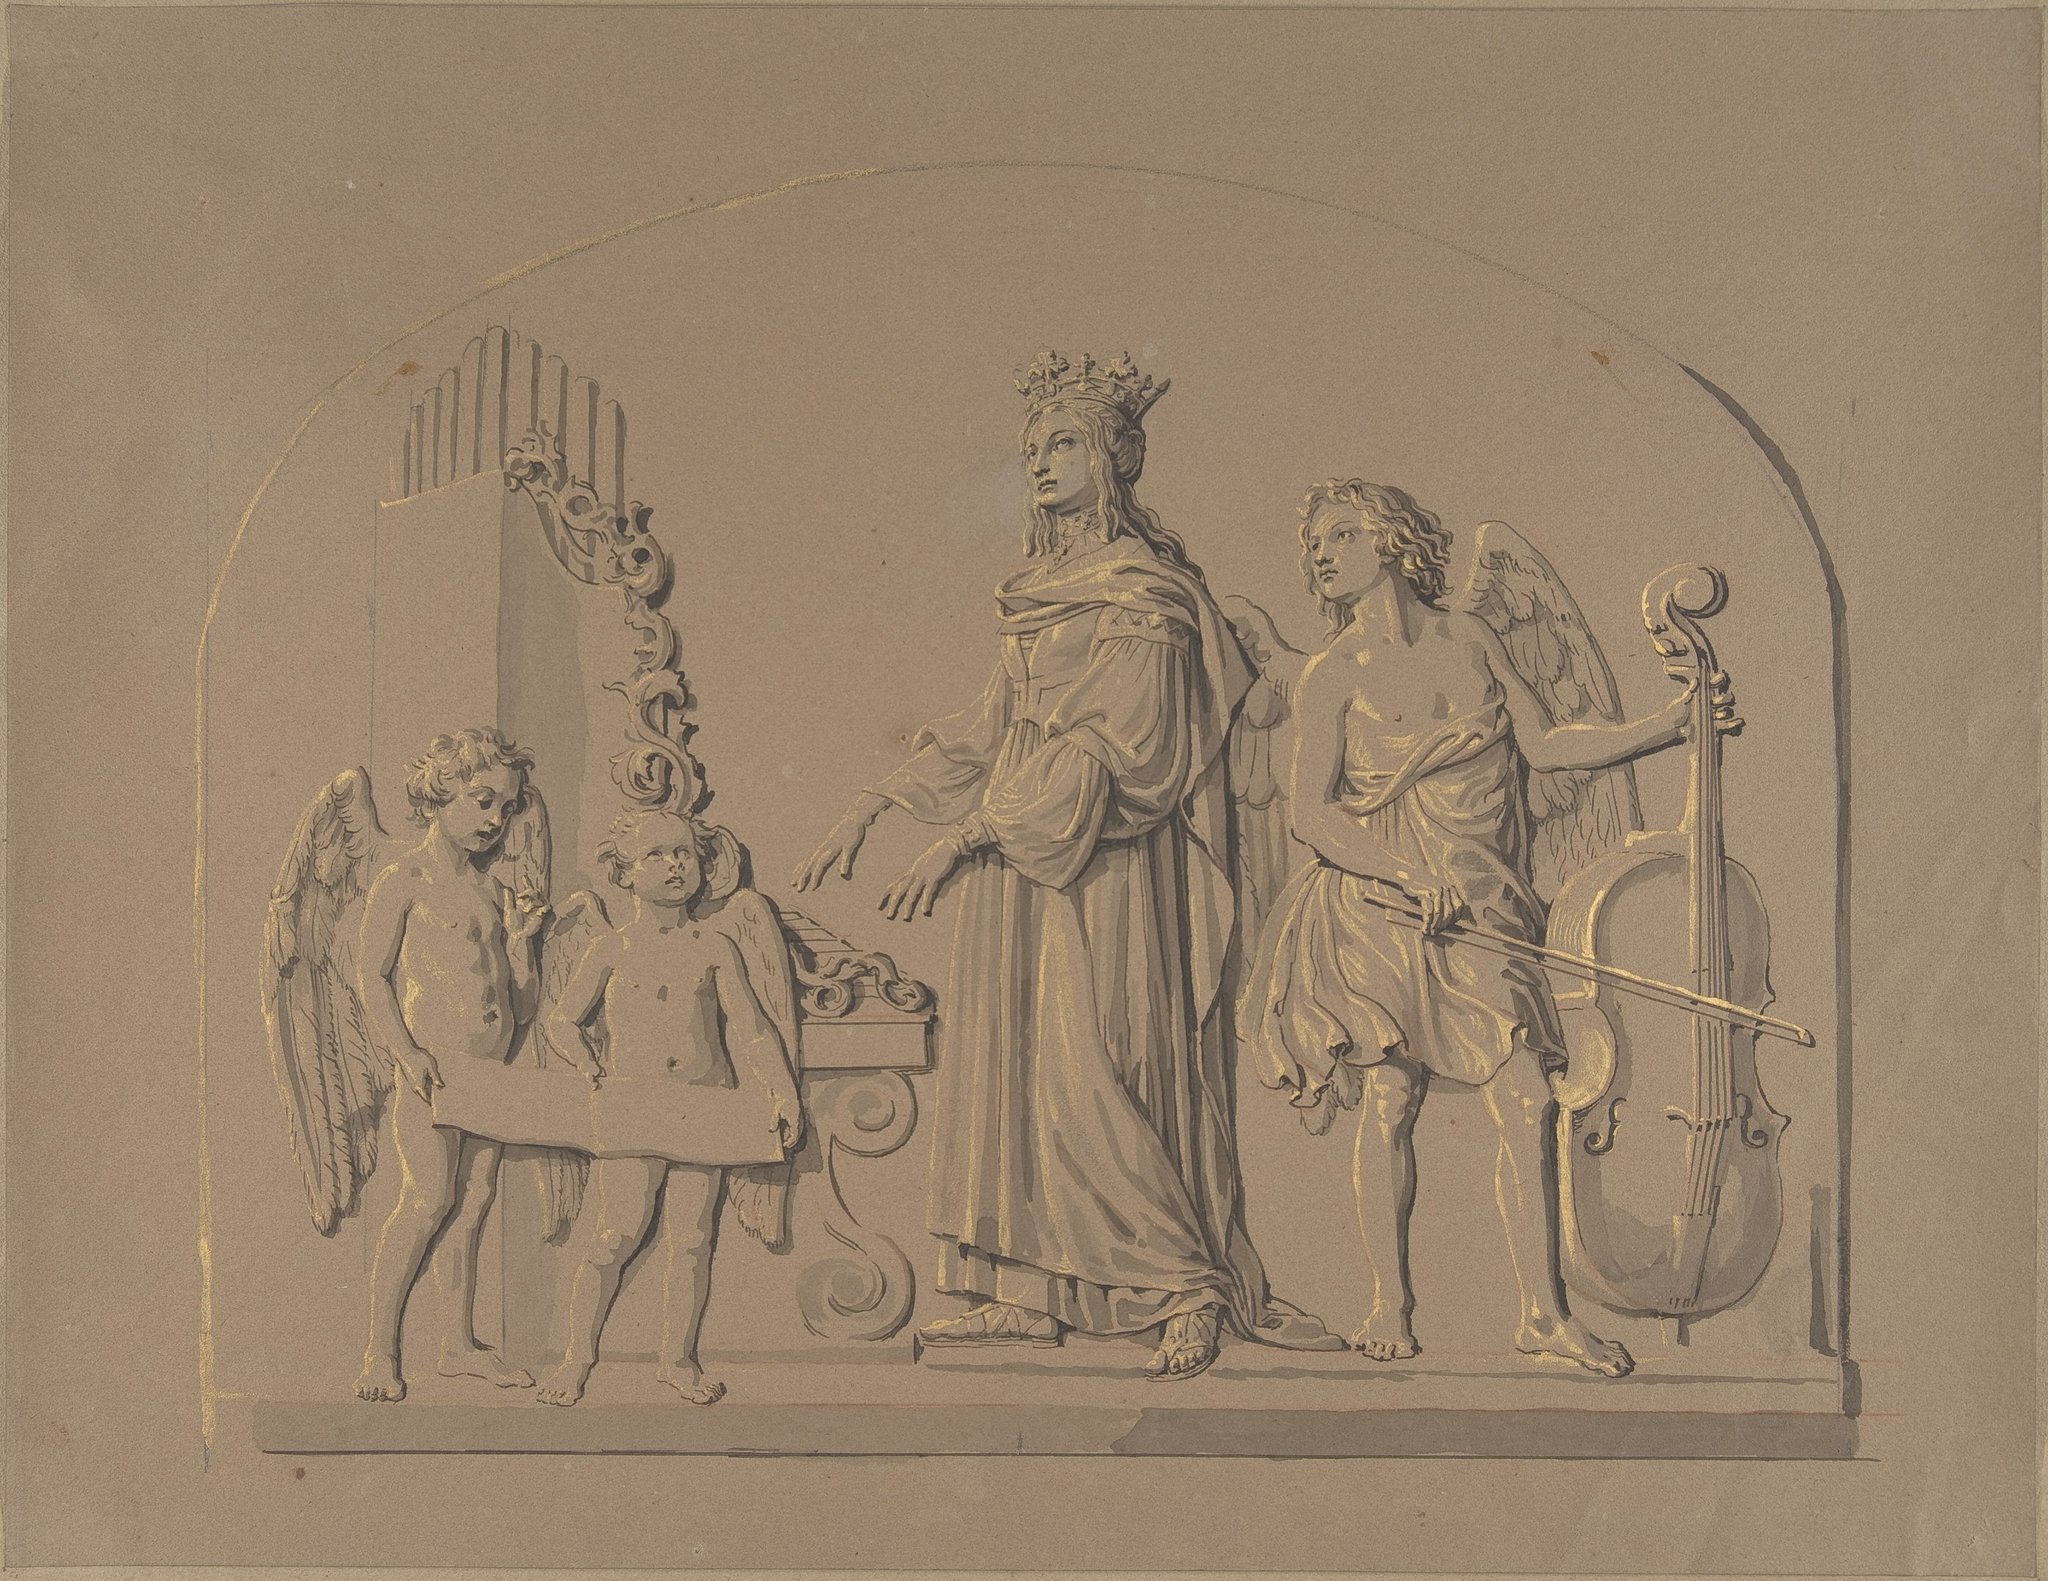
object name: drawing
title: Saint Cecilia at the Organ, Flanked by Angels Making Music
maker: johann gottfried schadow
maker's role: artist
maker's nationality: german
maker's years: 1764-1850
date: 1767-1866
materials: chalk, ink, pencil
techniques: brush, pen, wash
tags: musical instruments,angels,saints